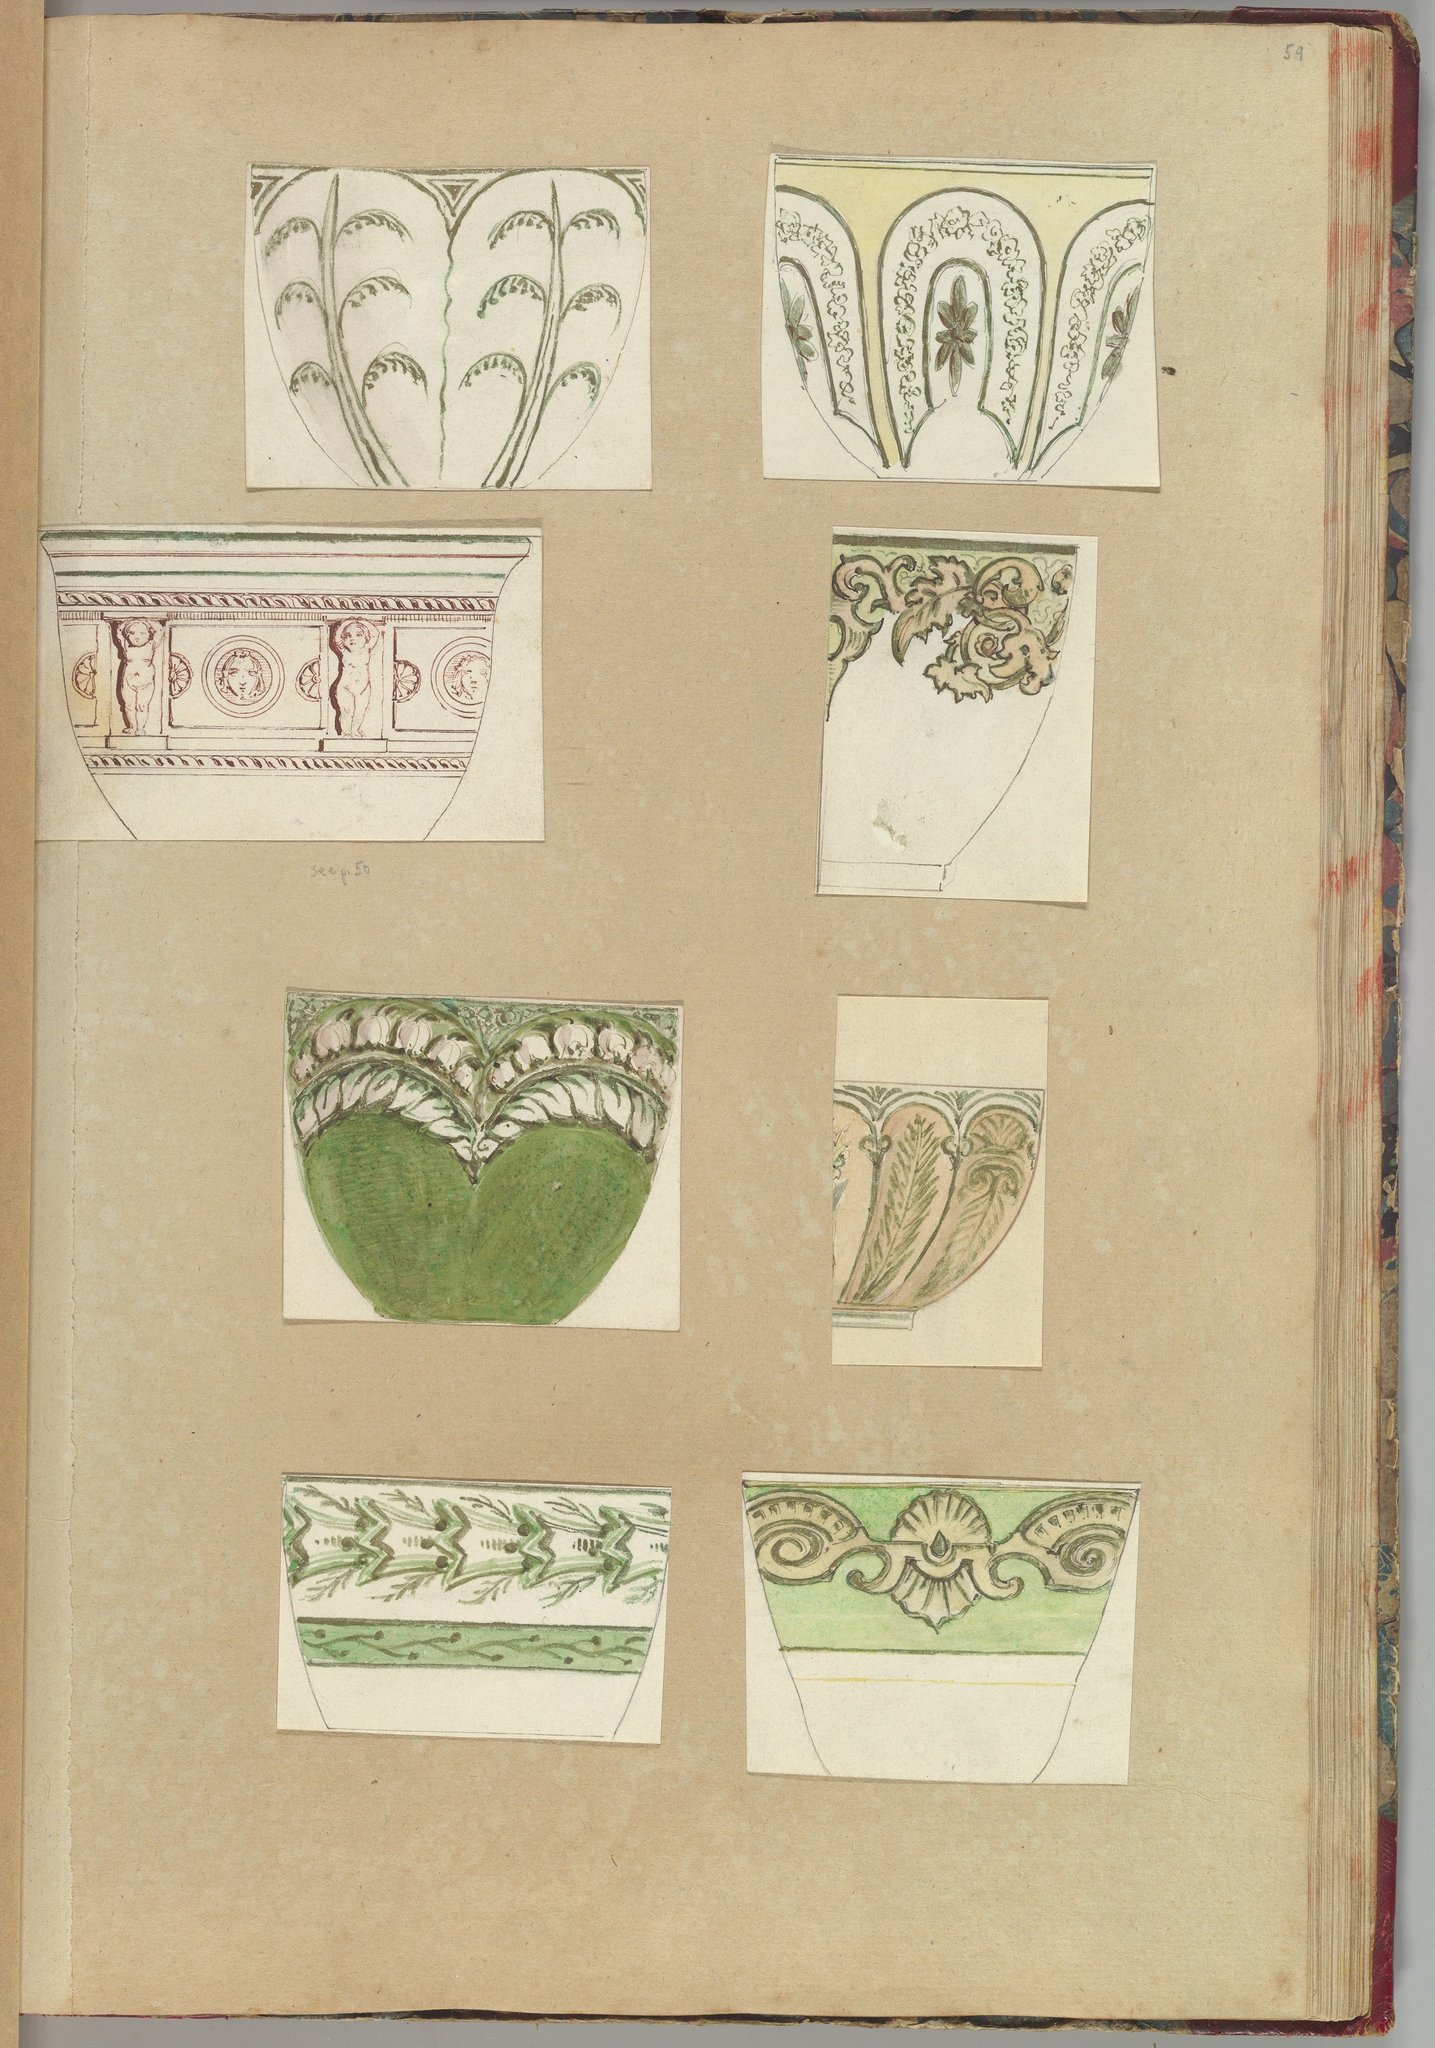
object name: drawing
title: Eight Designs for Decorated Cups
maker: alfred henry forrester [alfred crowquill]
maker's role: artist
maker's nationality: british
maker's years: 1804-1872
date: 1845-1855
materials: ink, watercolor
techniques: pen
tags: cups